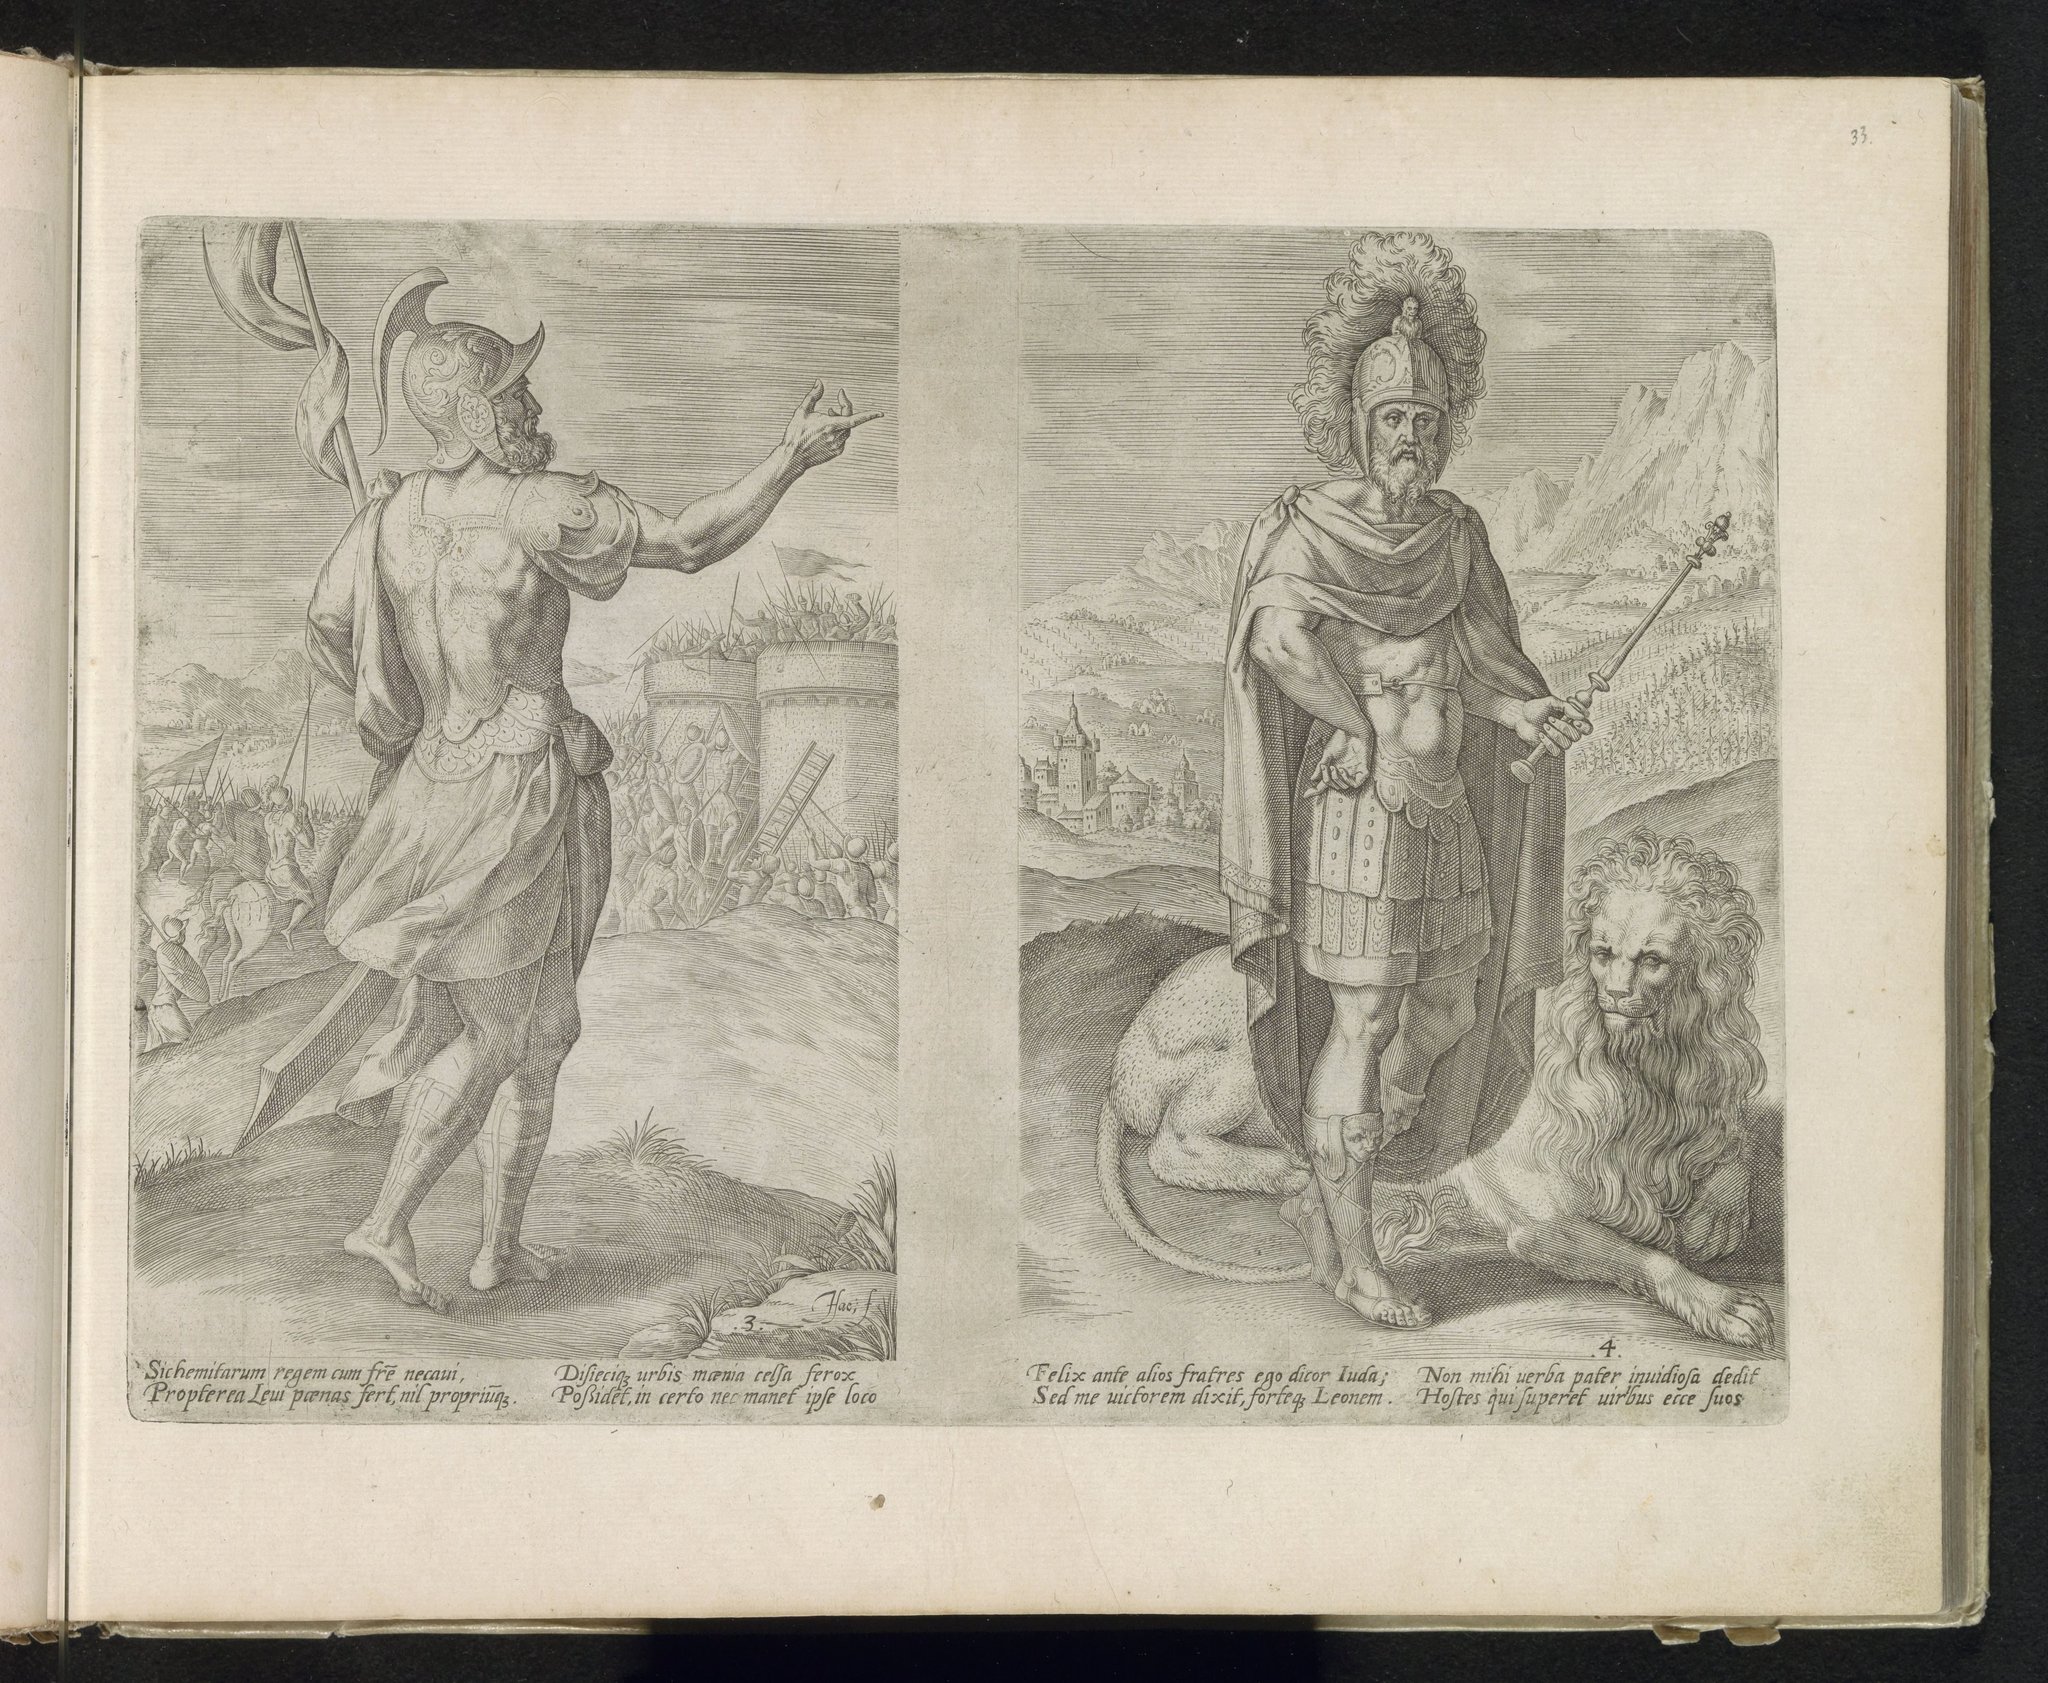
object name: print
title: Stamvaders Levi en Juda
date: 1585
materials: paper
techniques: engraving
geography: antwerp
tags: 11i611(juda), 11i611(levi)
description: Links stamvader Levi, de derde zoon van Jakob, in wapenrusting. Op de achtergrond de belegering van de stad Sichem, die Levi samen met Simeon vernietigde als wraak voor het onteren van hun zus Dina. Rechts stamvader Juda, de vierde zoon van Jakob, in wapenrusting. Aan zijn zijde een leeuw, een verwijzing naar de vergelijking die zijn vader Jakob maakt tussen Juda en een leeuw. Onder de voorstellingen een verwijzing in het Latijn naar de Bijbeltekst. Deze prent maakt deel uit van een album.